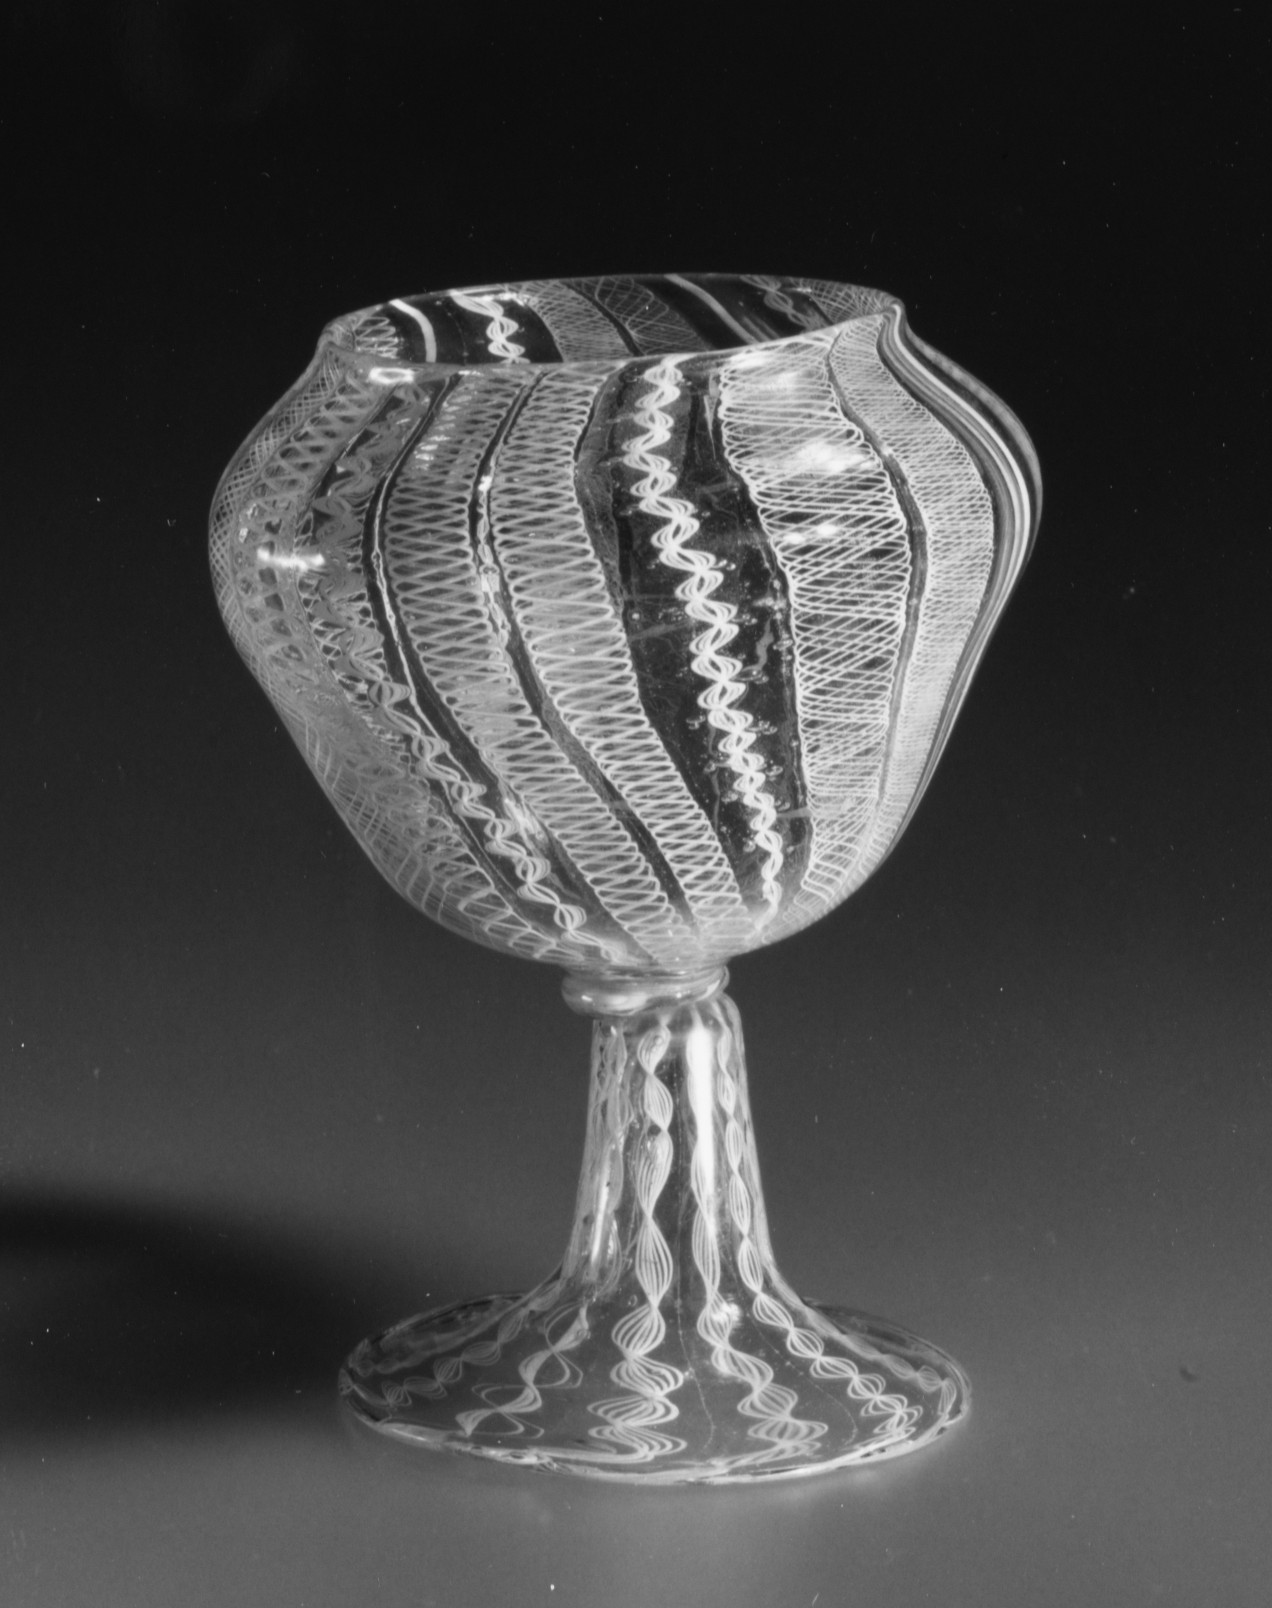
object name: vase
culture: italian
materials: glass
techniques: glassblowing